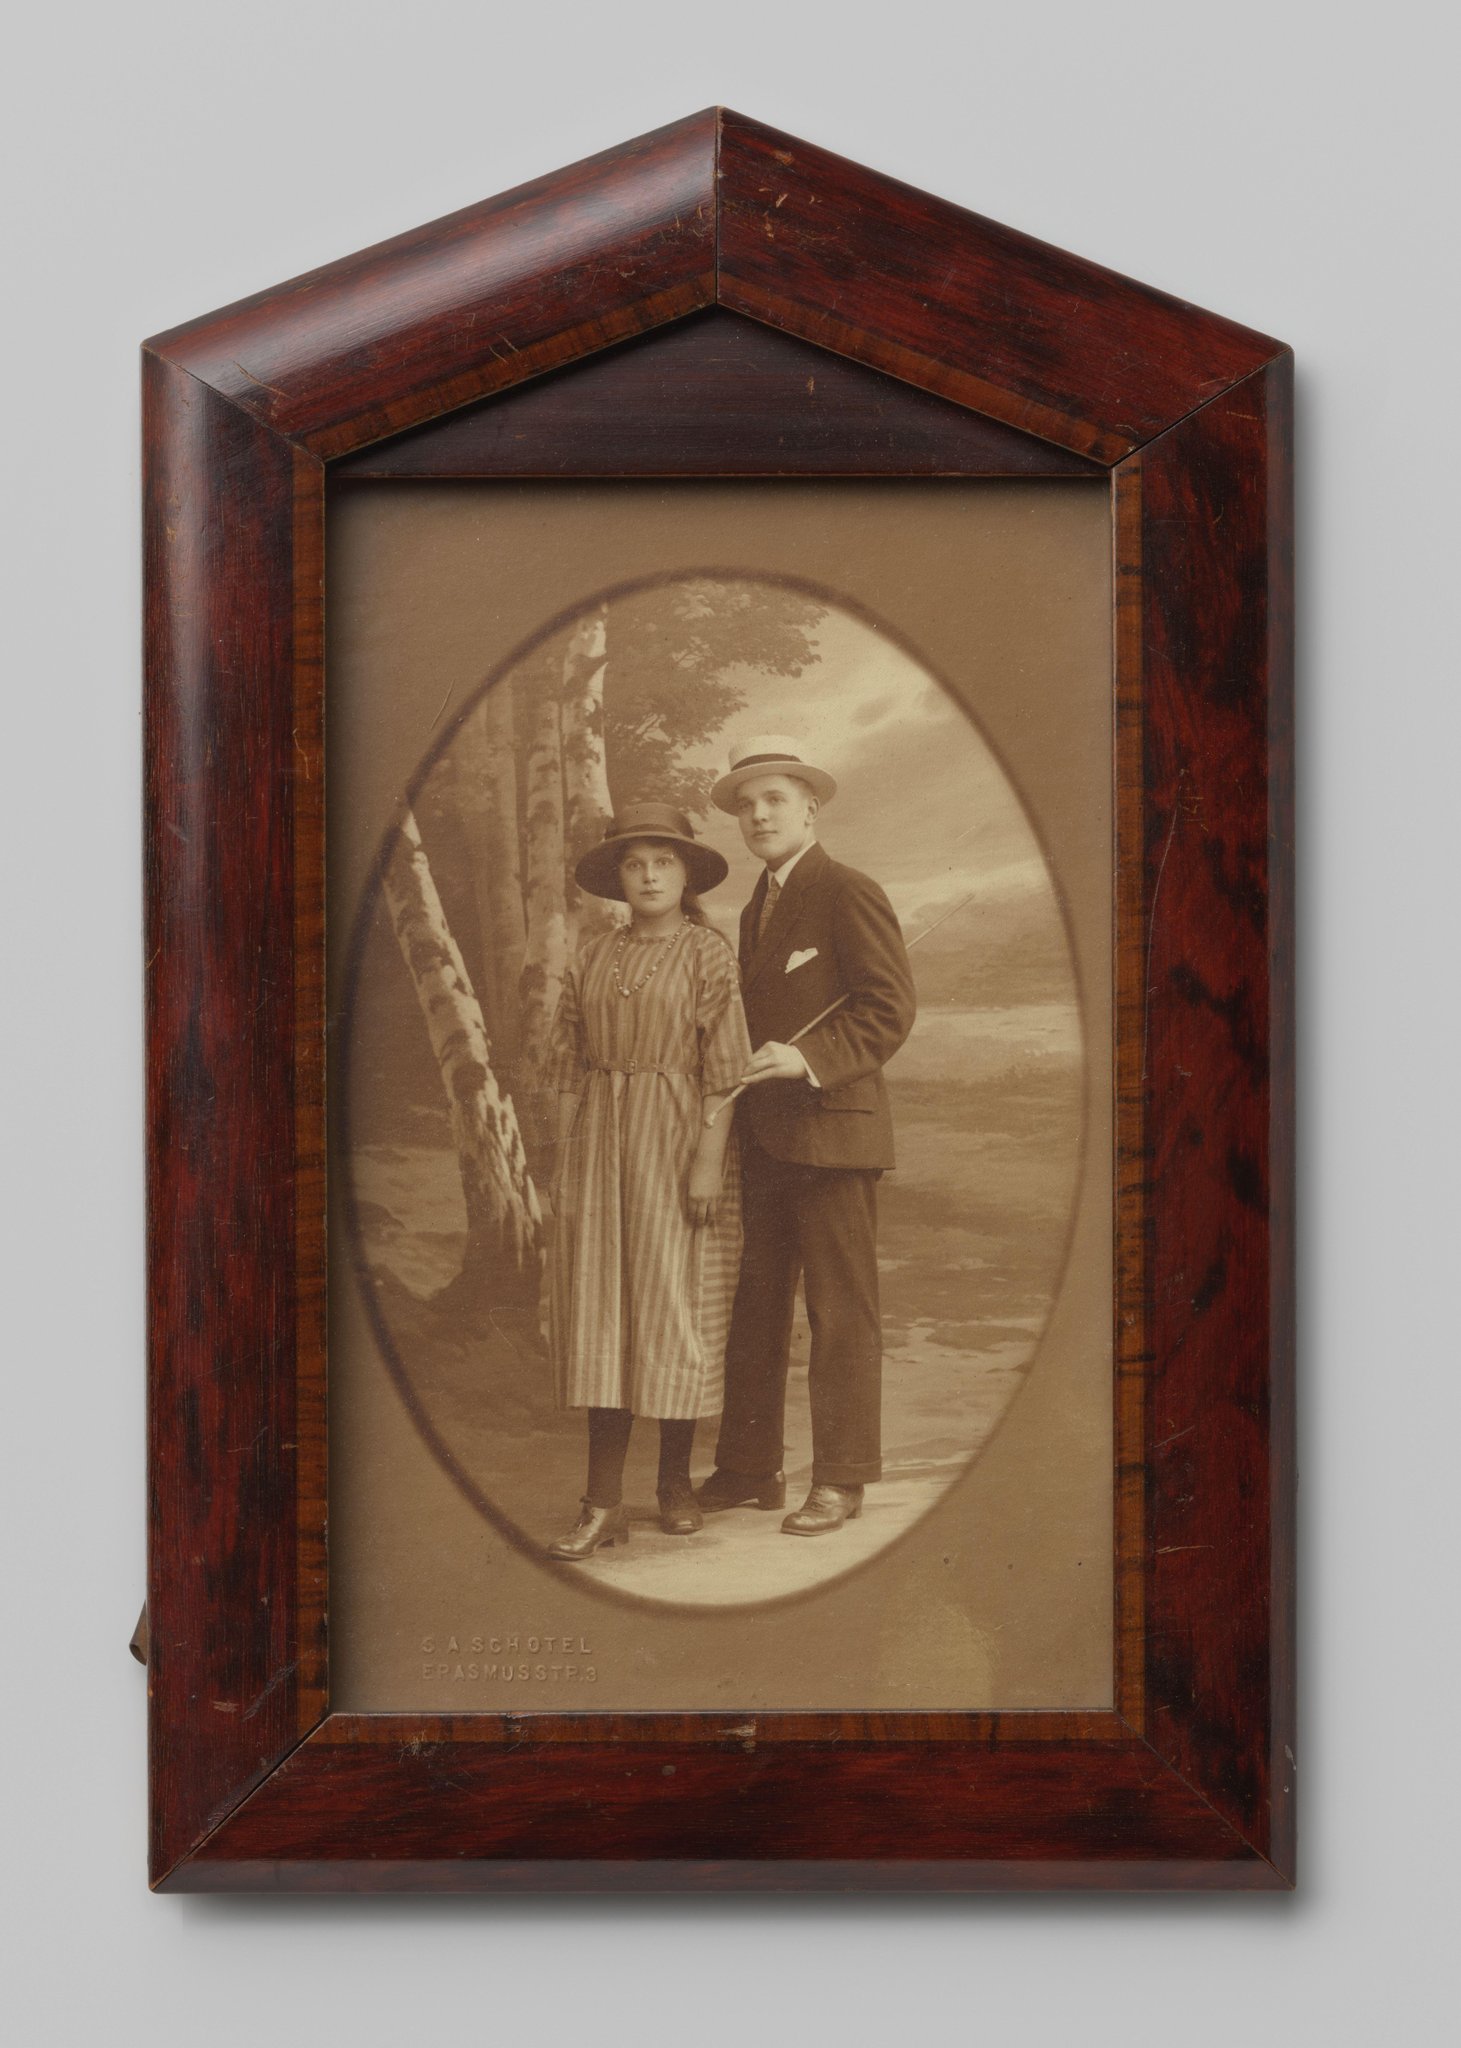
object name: frame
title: Portret van een onbekende jongen en meisje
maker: stephanus adrianus schotel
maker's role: fotograaf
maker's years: 1871-1957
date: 1906-1909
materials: paper, cardboard, glass, metal, pressure sensitive tape, wood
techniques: gelatin silver print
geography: rotterdam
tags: boy (child between toddler and youth), walking-stick, staff, girl (child between toddler and youth), head-gear: hat, anonymous historical person portrayed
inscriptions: check stamp: ‘S A SCHOTEL/ ERASUMUSSTR. 3’, inscription: ‘1,20 Aa’